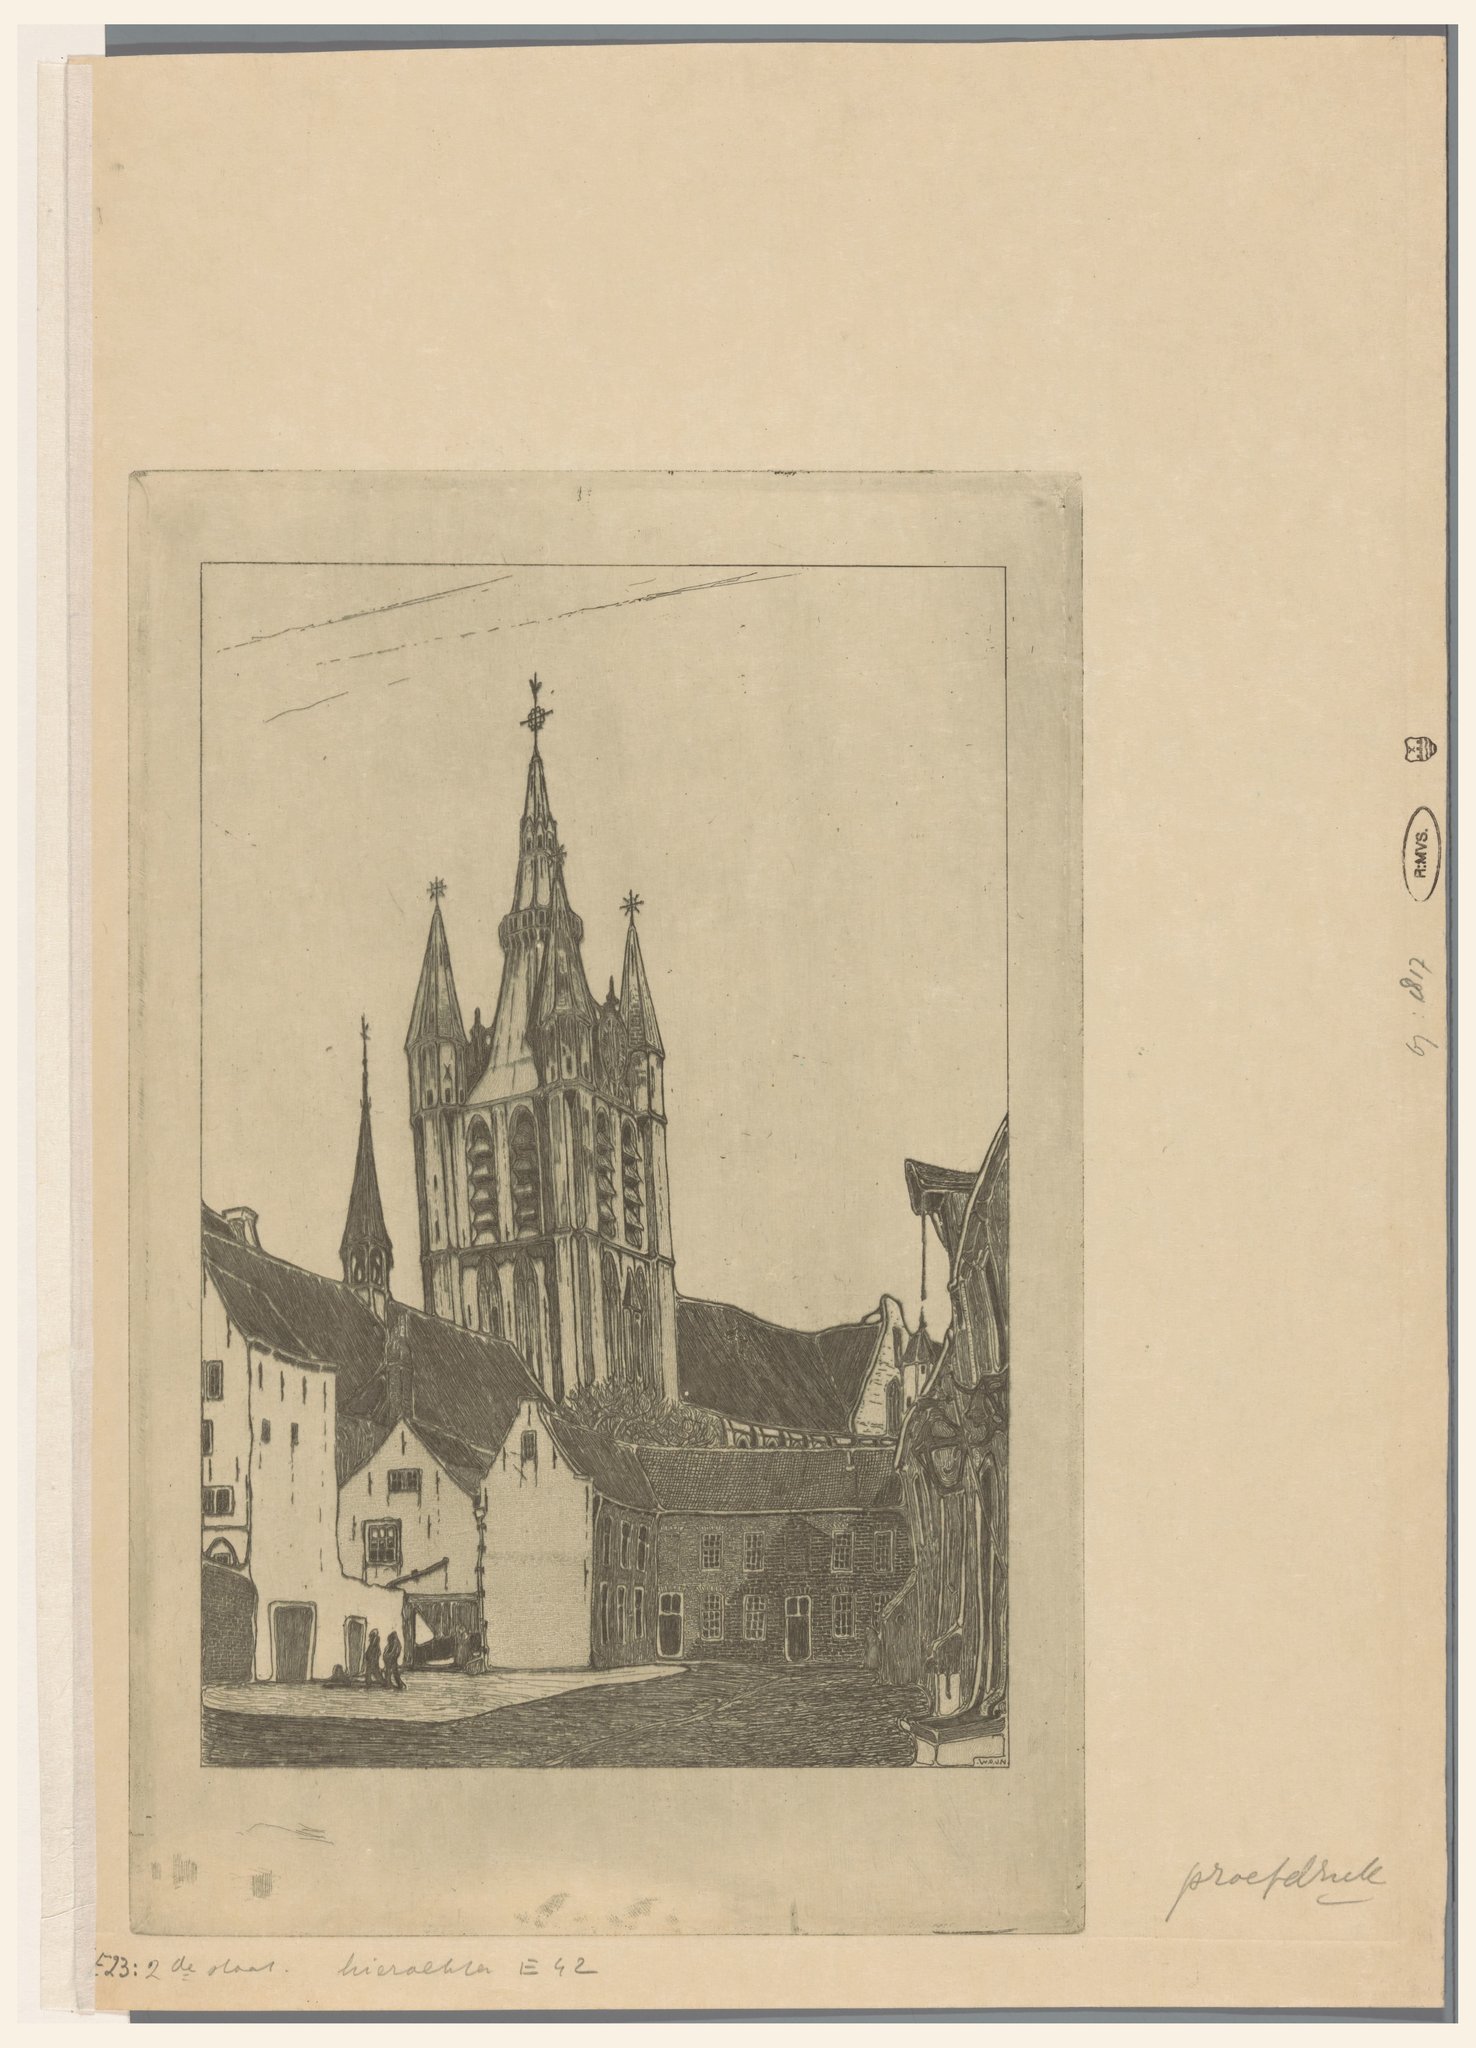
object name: print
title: Toren van de Oude Kerk in Delft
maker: wijnand otto jan nieuwenkamp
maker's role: draughtsman, print maker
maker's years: 1874-1950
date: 1897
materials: paper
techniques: etching, intaglio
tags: barracks, parts of church exterior and annexes: tower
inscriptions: collector's mark: Lugt 2760, collector's mark: Lugt 2228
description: Op de voorgrond de binnenplaats van het Prinsenhof, waarvan een gedeelte diende als kazerne.